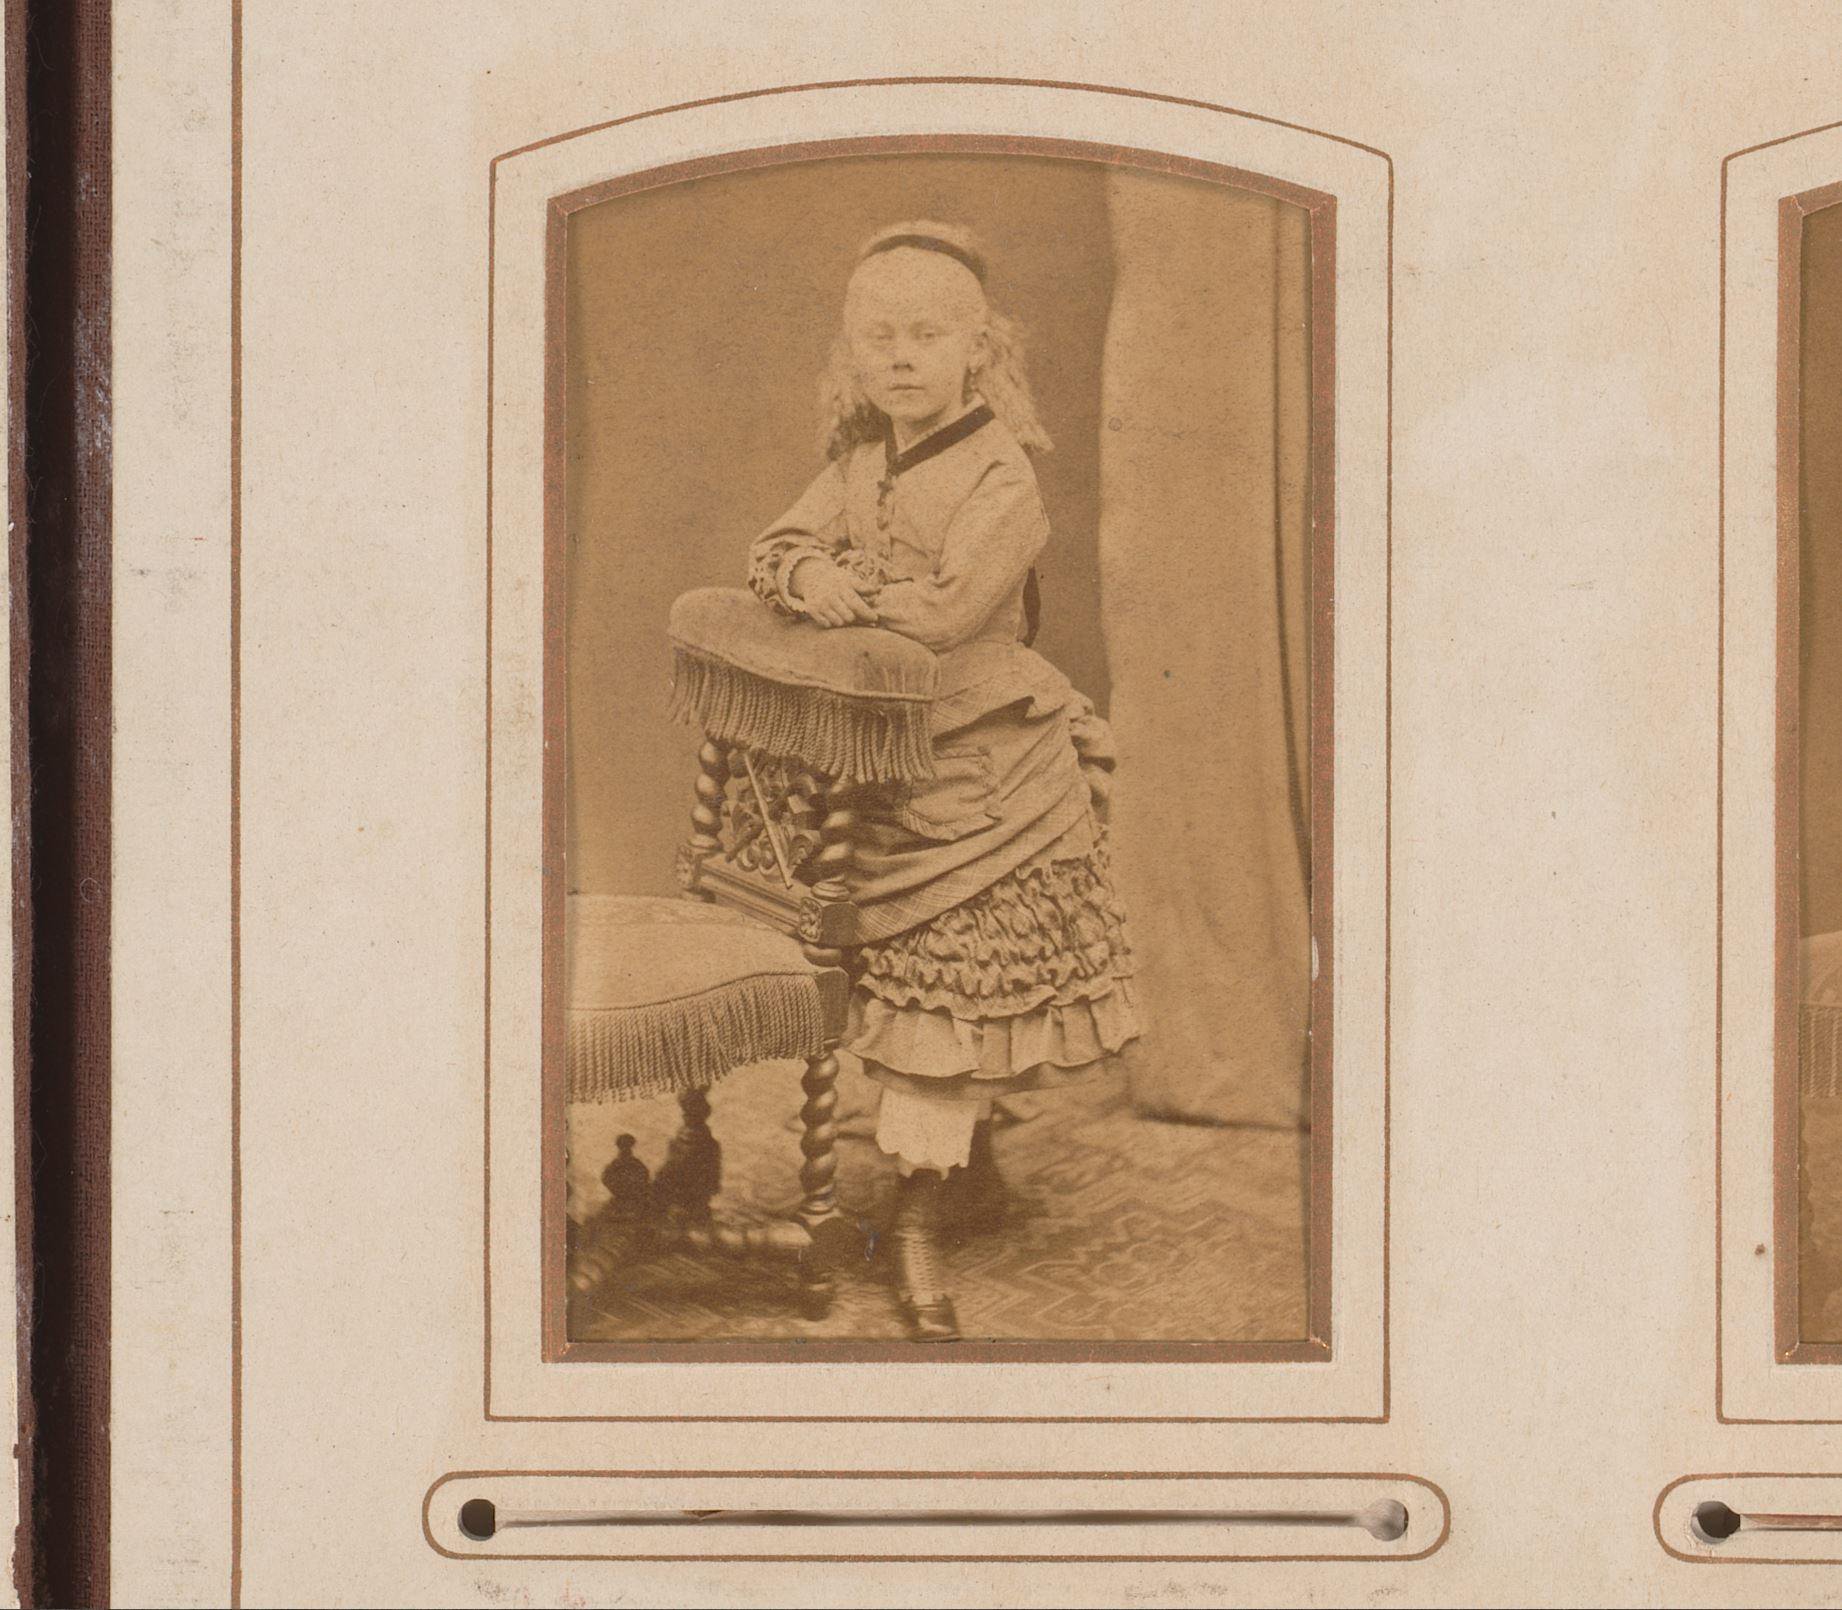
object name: carte de visite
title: Portret van een meisje, staand bij een stoel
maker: hermanus jodocus weesing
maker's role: fotograaf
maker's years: 1844-1910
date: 1868-1900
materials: cardboard, photographic support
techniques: albumen print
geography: amsterdam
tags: girl (child between toddler and youth), standing figure - aa - female human figure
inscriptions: inscription: ‘H.J. Weesing/ Amsterdam’